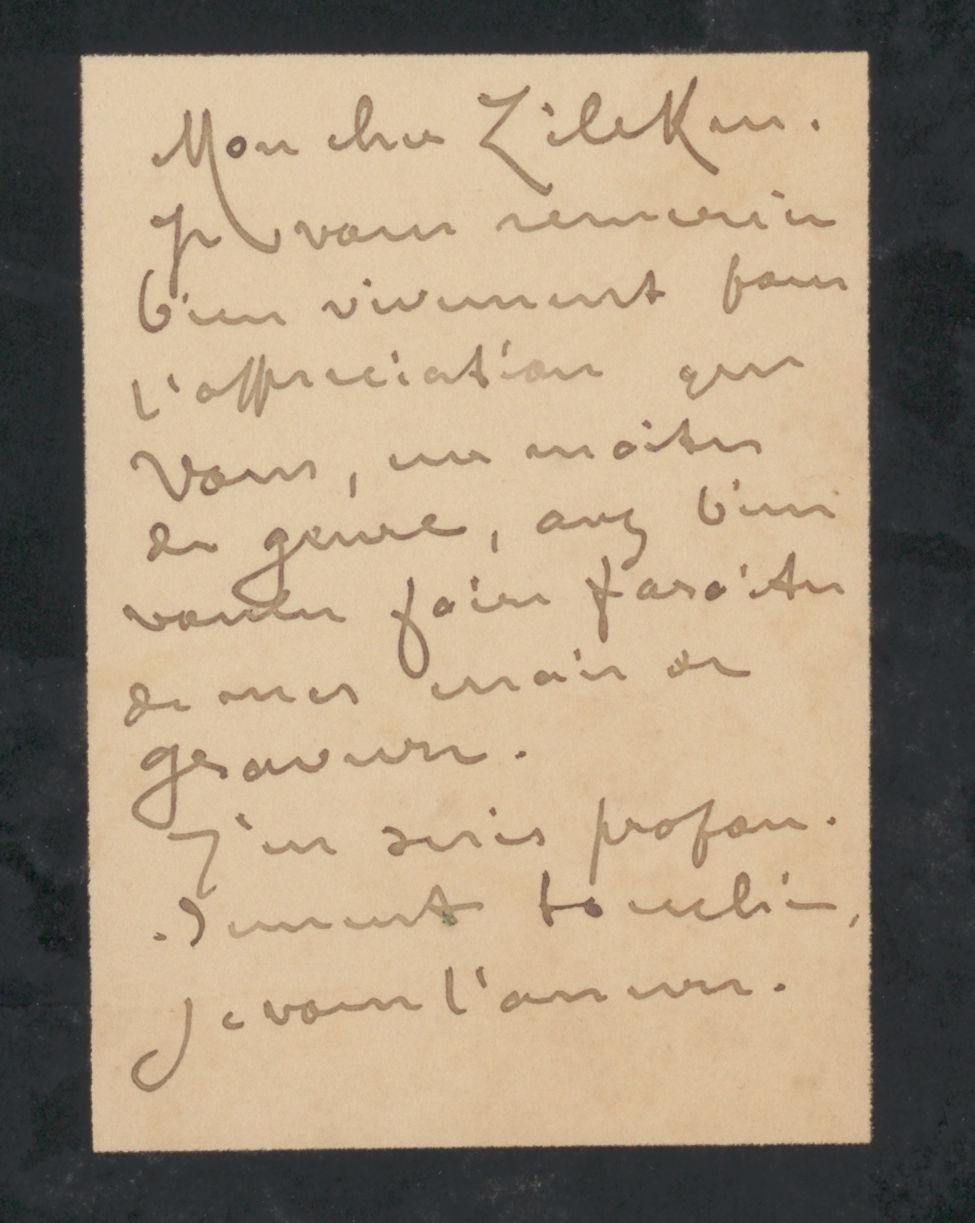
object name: letter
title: Brief aan Philip Zilcken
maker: fernand khnopff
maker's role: draughtsman, print maker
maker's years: 1858-1921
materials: ink, paper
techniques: pen, writing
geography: brussels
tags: the hague, painter, draughtsman, philip zilcken, the graphic arts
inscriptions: collector's mark: ‘RPK’